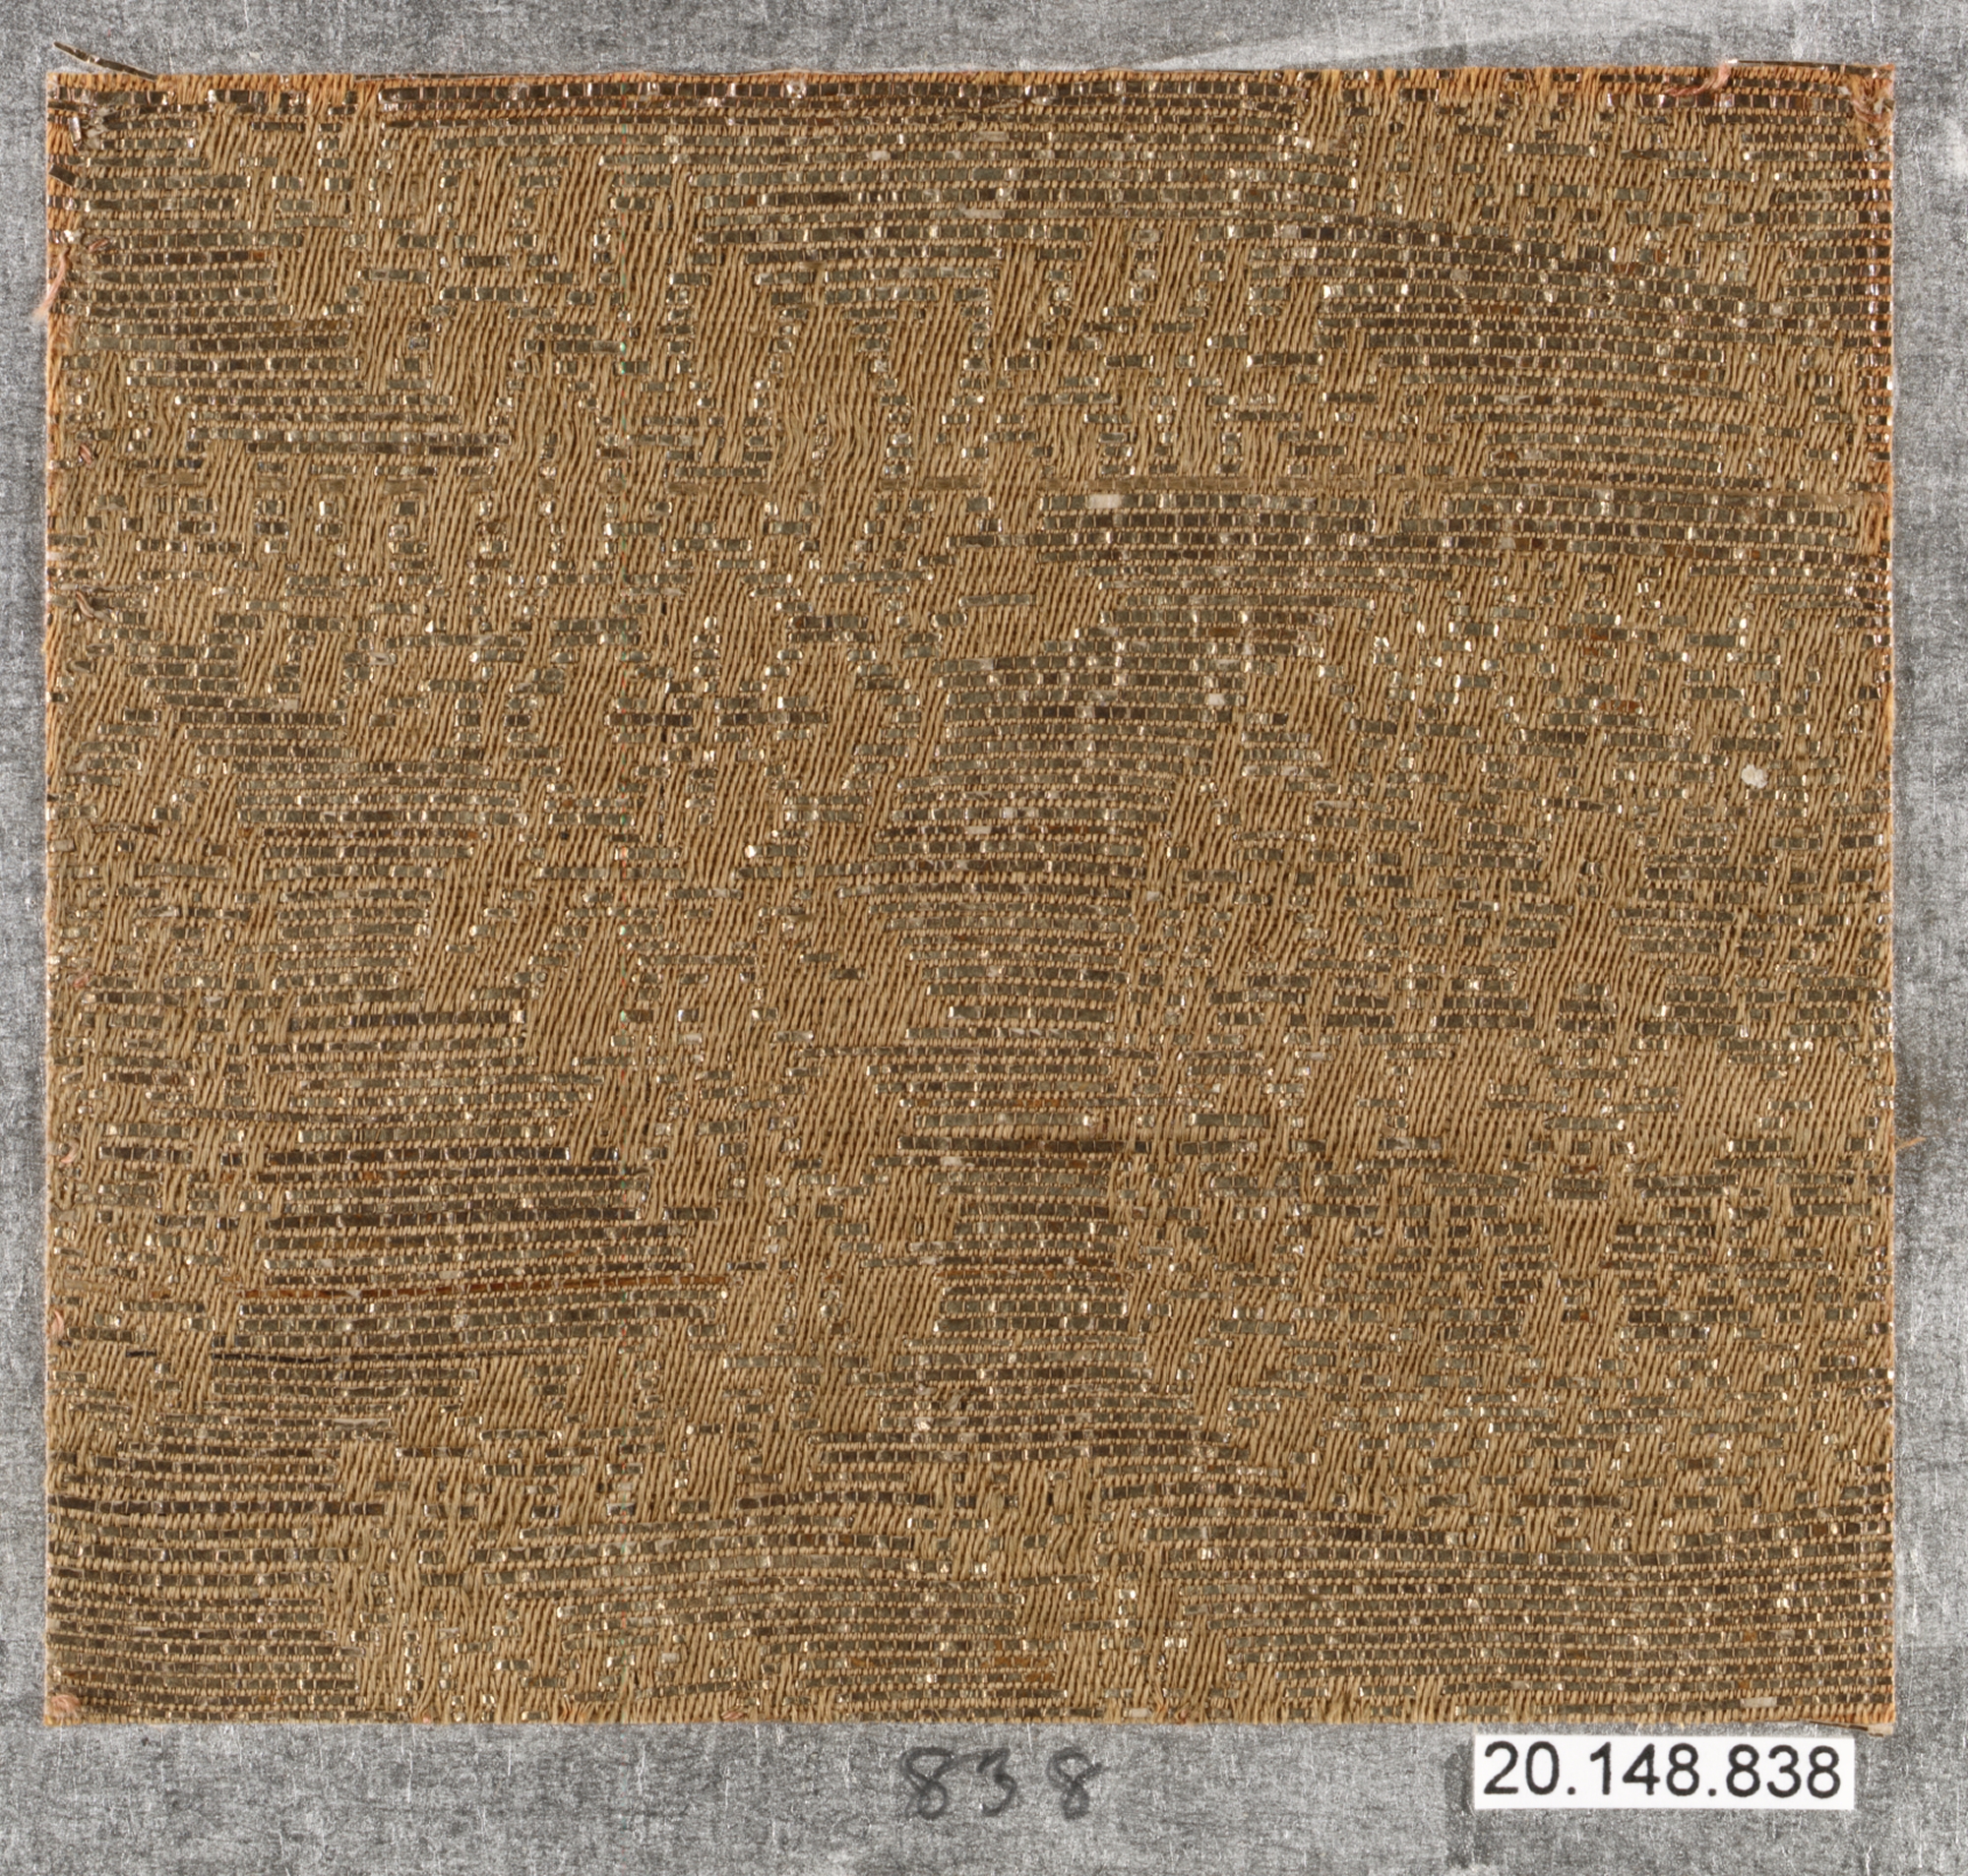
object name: piece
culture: japanese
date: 1701-1800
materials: silk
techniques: compound weave